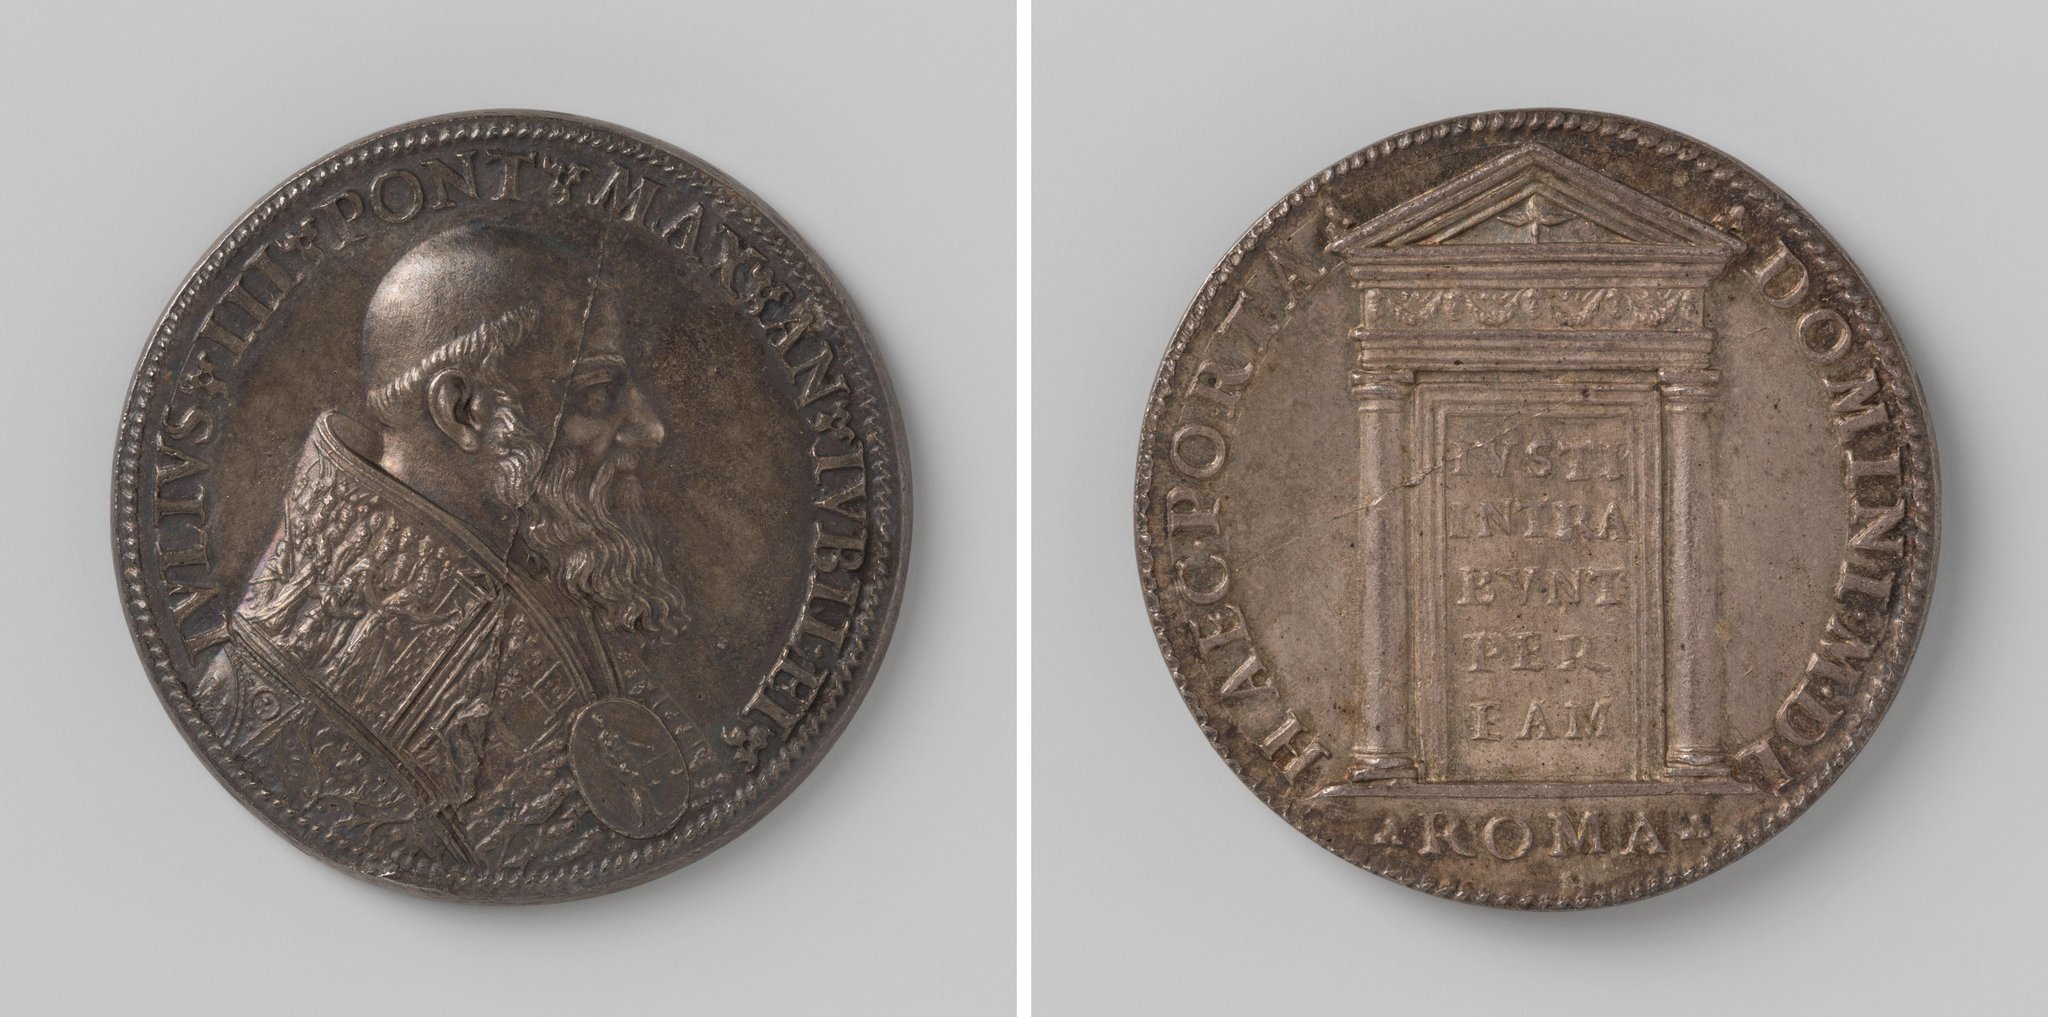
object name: history medal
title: Jubeljaar afgekondigd door paus Julius III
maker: giovan giacomo bonzagni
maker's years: 1507-1565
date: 1550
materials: silver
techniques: striking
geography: rome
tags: paus, julius iii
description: Zilveren penning. Voorzijde: borststuk man binnen omschrift. Keerzijde: Porta Santa met opschrift binnen omschrift; afsnede: opschrift